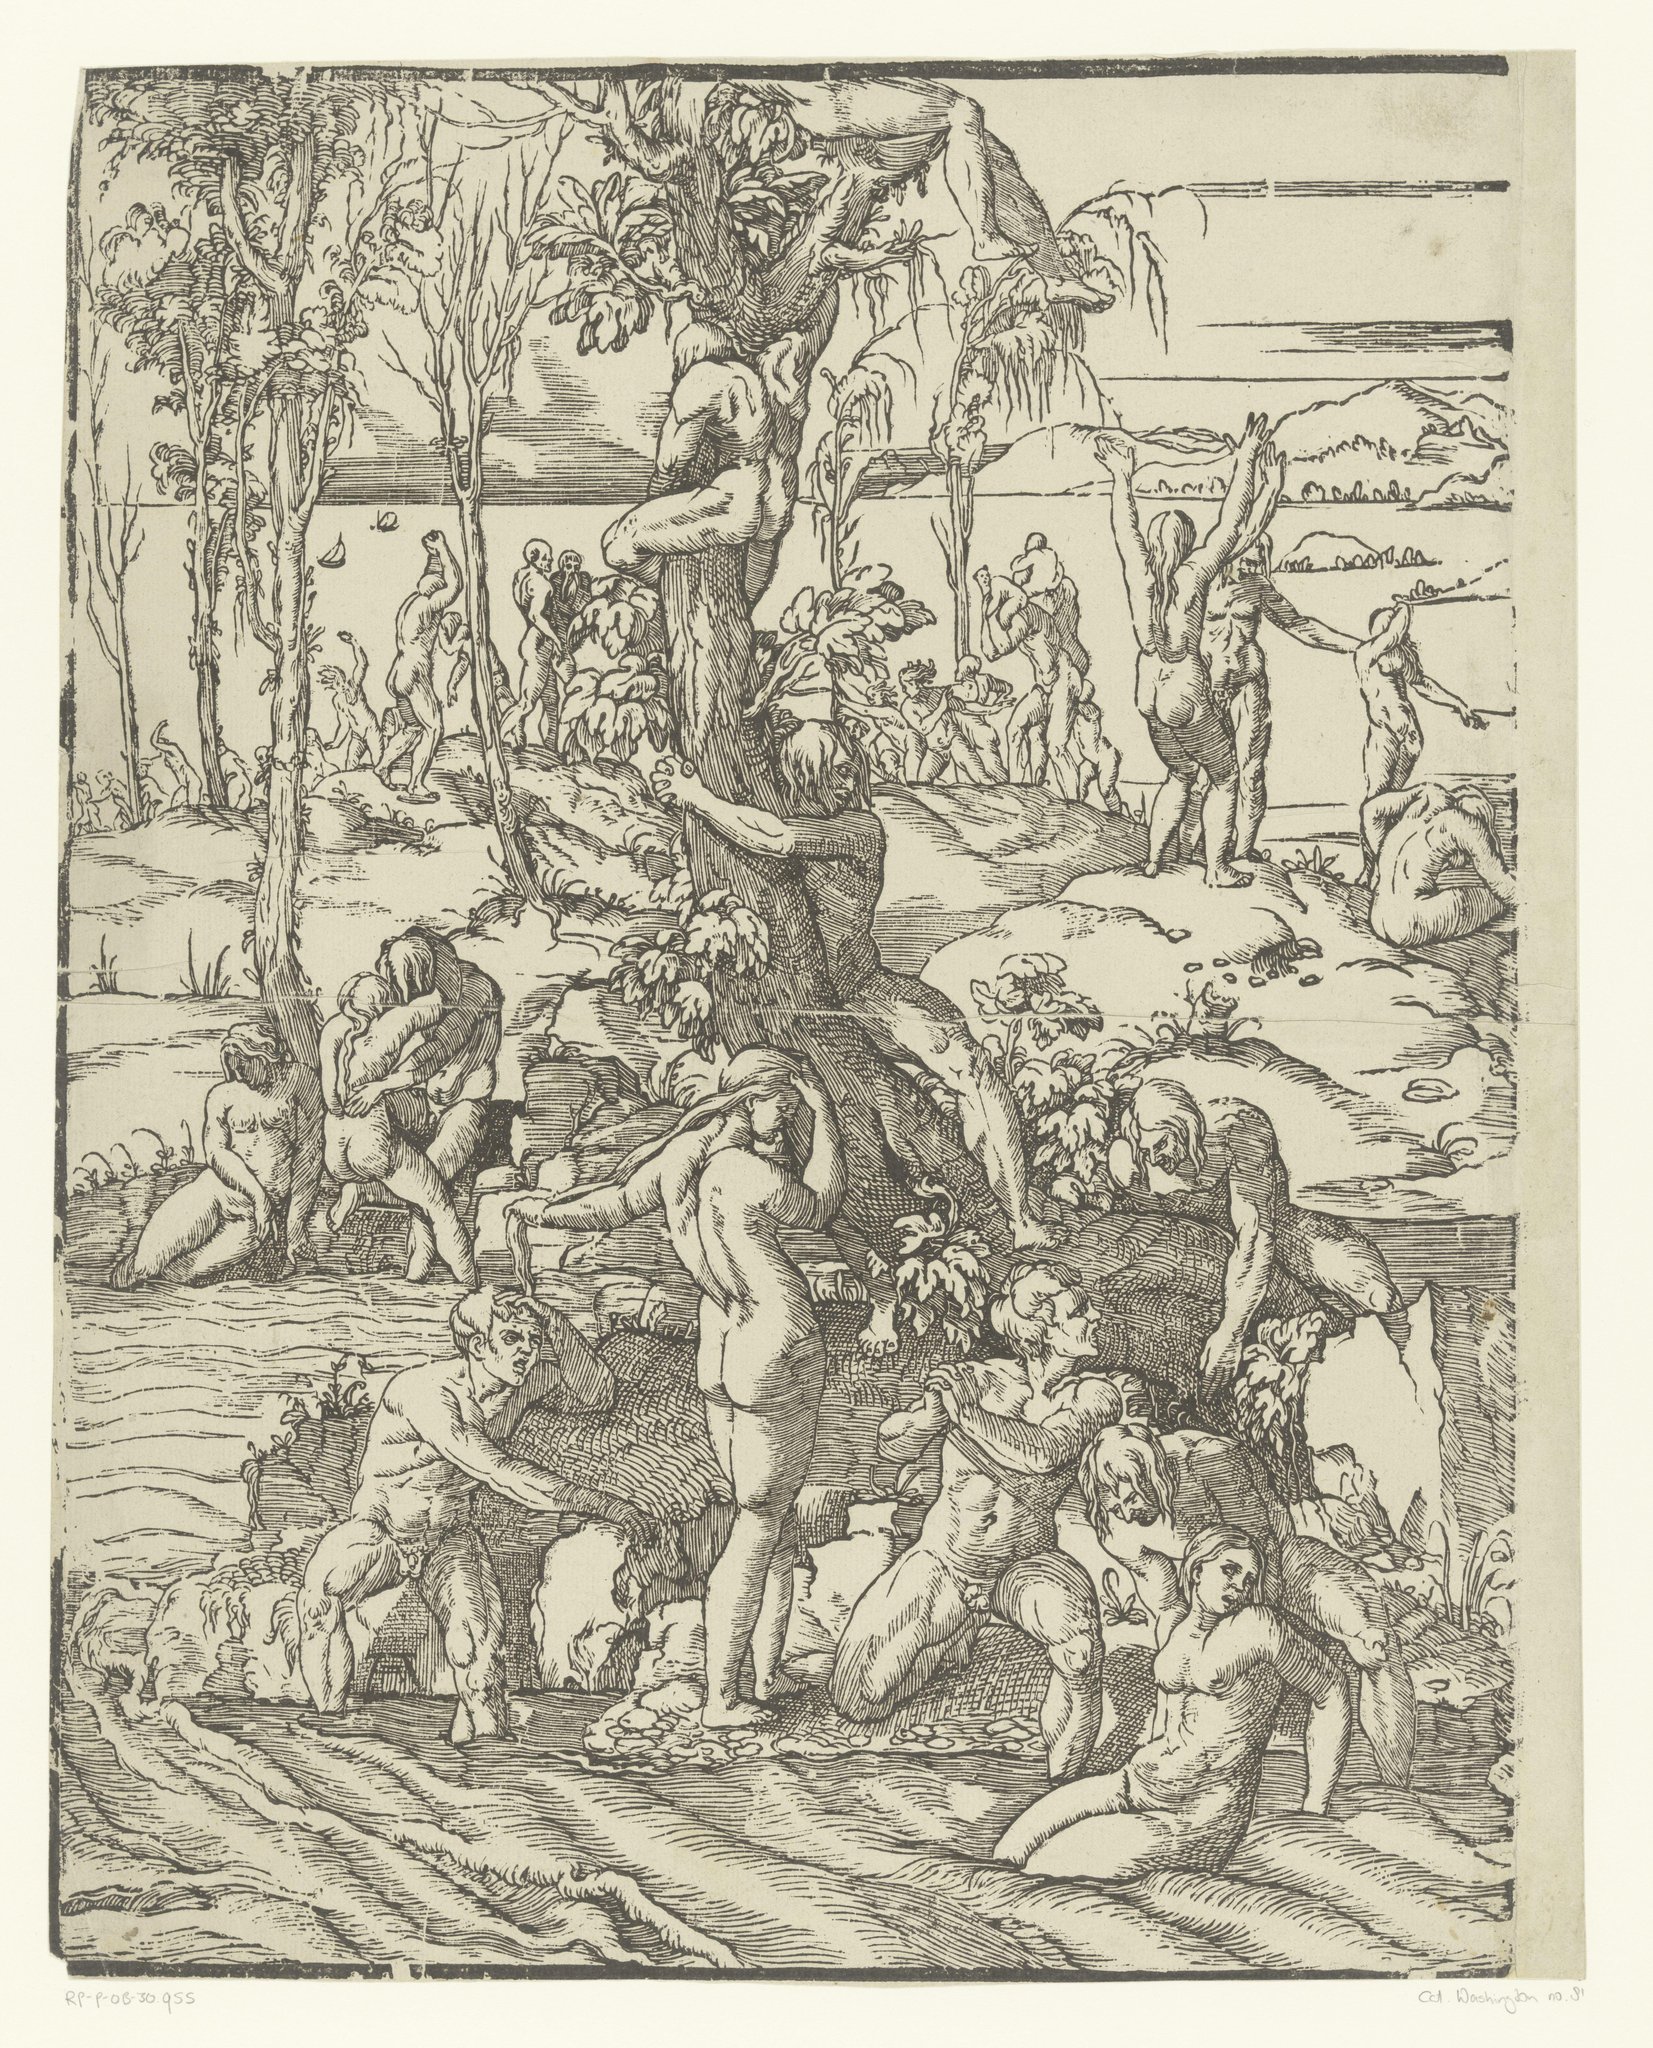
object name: print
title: Zondvloed (linkerhelft)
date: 1568-1629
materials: paper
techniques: woodcut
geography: venice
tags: the ark is floating on the waters, while life on earth is destroyed ~ story of noah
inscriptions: collector's mark: Lugt 240, number: ‘579’, inscription: ‘l'abecedario pittorico pag. 505 n. 32. dit teken ter regter zijde van deze print is van Agnese Freij vroúwe van Albert Durer, of van een zijner discipels.’, inscription: ‘Holbein’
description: Mannen en vrouwen proberen zichzelf en anderen in veiligheid te brengen tijdens de Zondvloed. Rechts een tempel en op het water de ark van Noach.